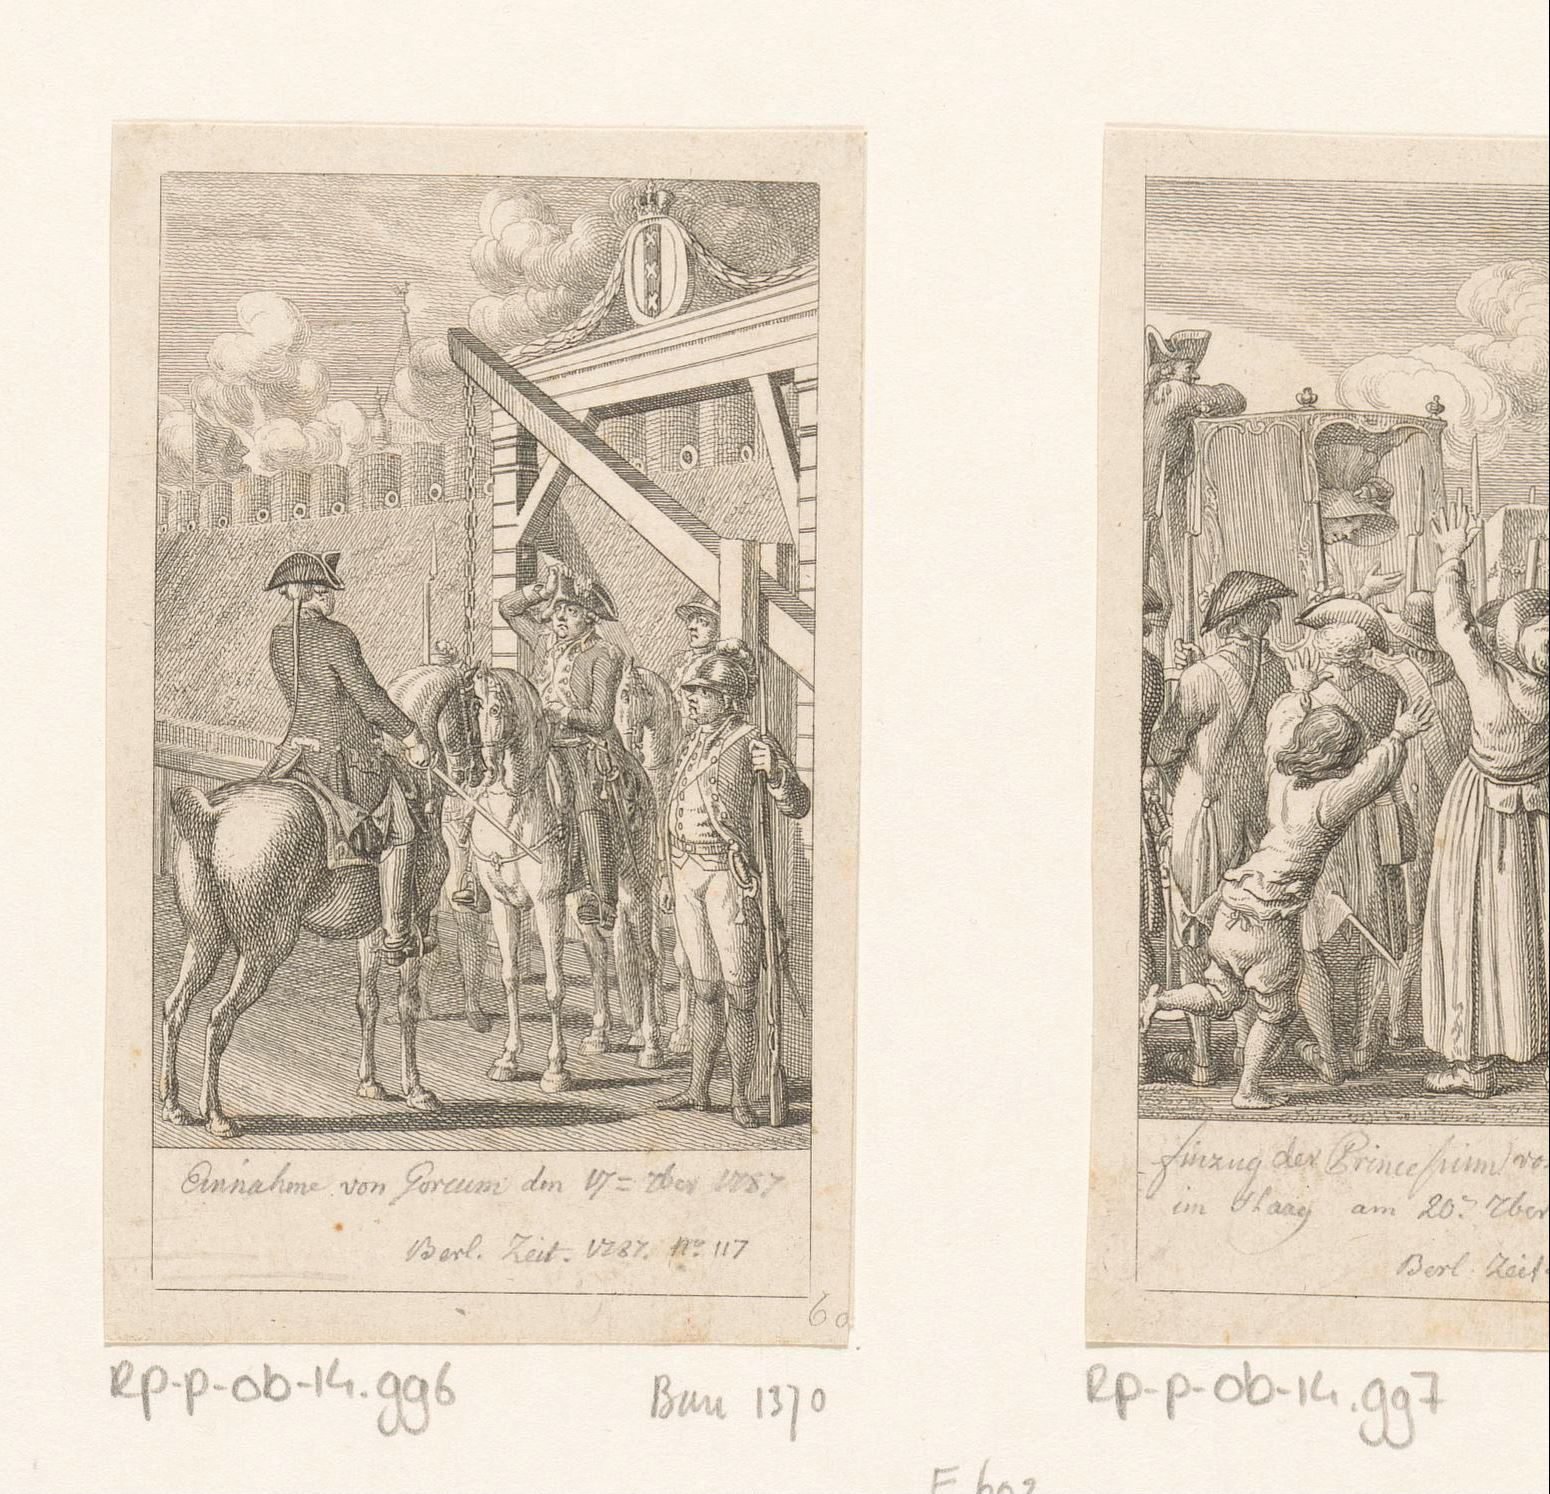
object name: print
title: Inname van de vesting Gorinchem op 17 september 1787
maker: daniel nikolaus chodowiecki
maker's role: draughtsman, print maker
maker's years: 1726-1801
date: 1788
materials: paper, pencil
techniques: etching, handwriting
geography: berlin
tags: berlin, frederik willem ii (koning van pruisen), history, battle, city-gate, siege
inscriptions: collector's mark: Lugt 2228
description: Latere staat gebruikt voor: Genealogischer-Militairischer Kalender auf das Jahr 1789. Berlijn: s.n., [1788].